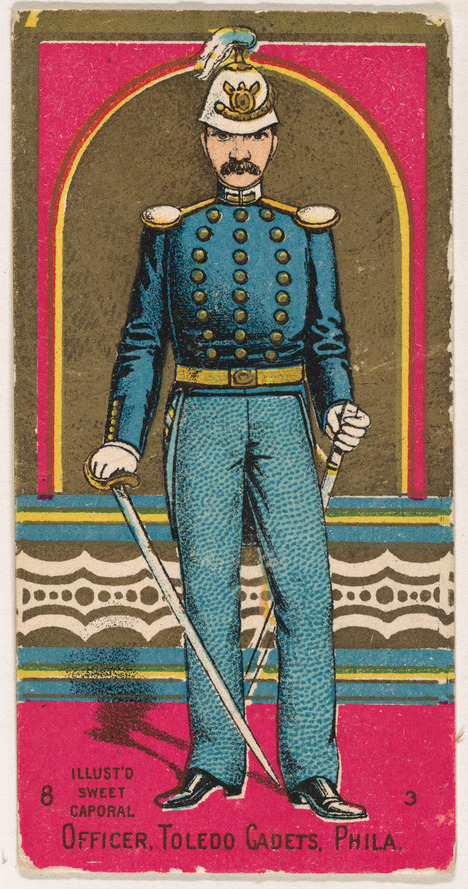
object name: print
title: Officer, Toledo Cadets, Philadelphia, from the Military Series (N224) issued by Kinney Tobacco Company to promote Sweet Caporal Cigarettes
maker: kinney brothers tobacco company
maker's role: publisher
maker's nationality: american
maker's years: 1869-2011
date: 1888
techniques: color lithograph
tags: military,men